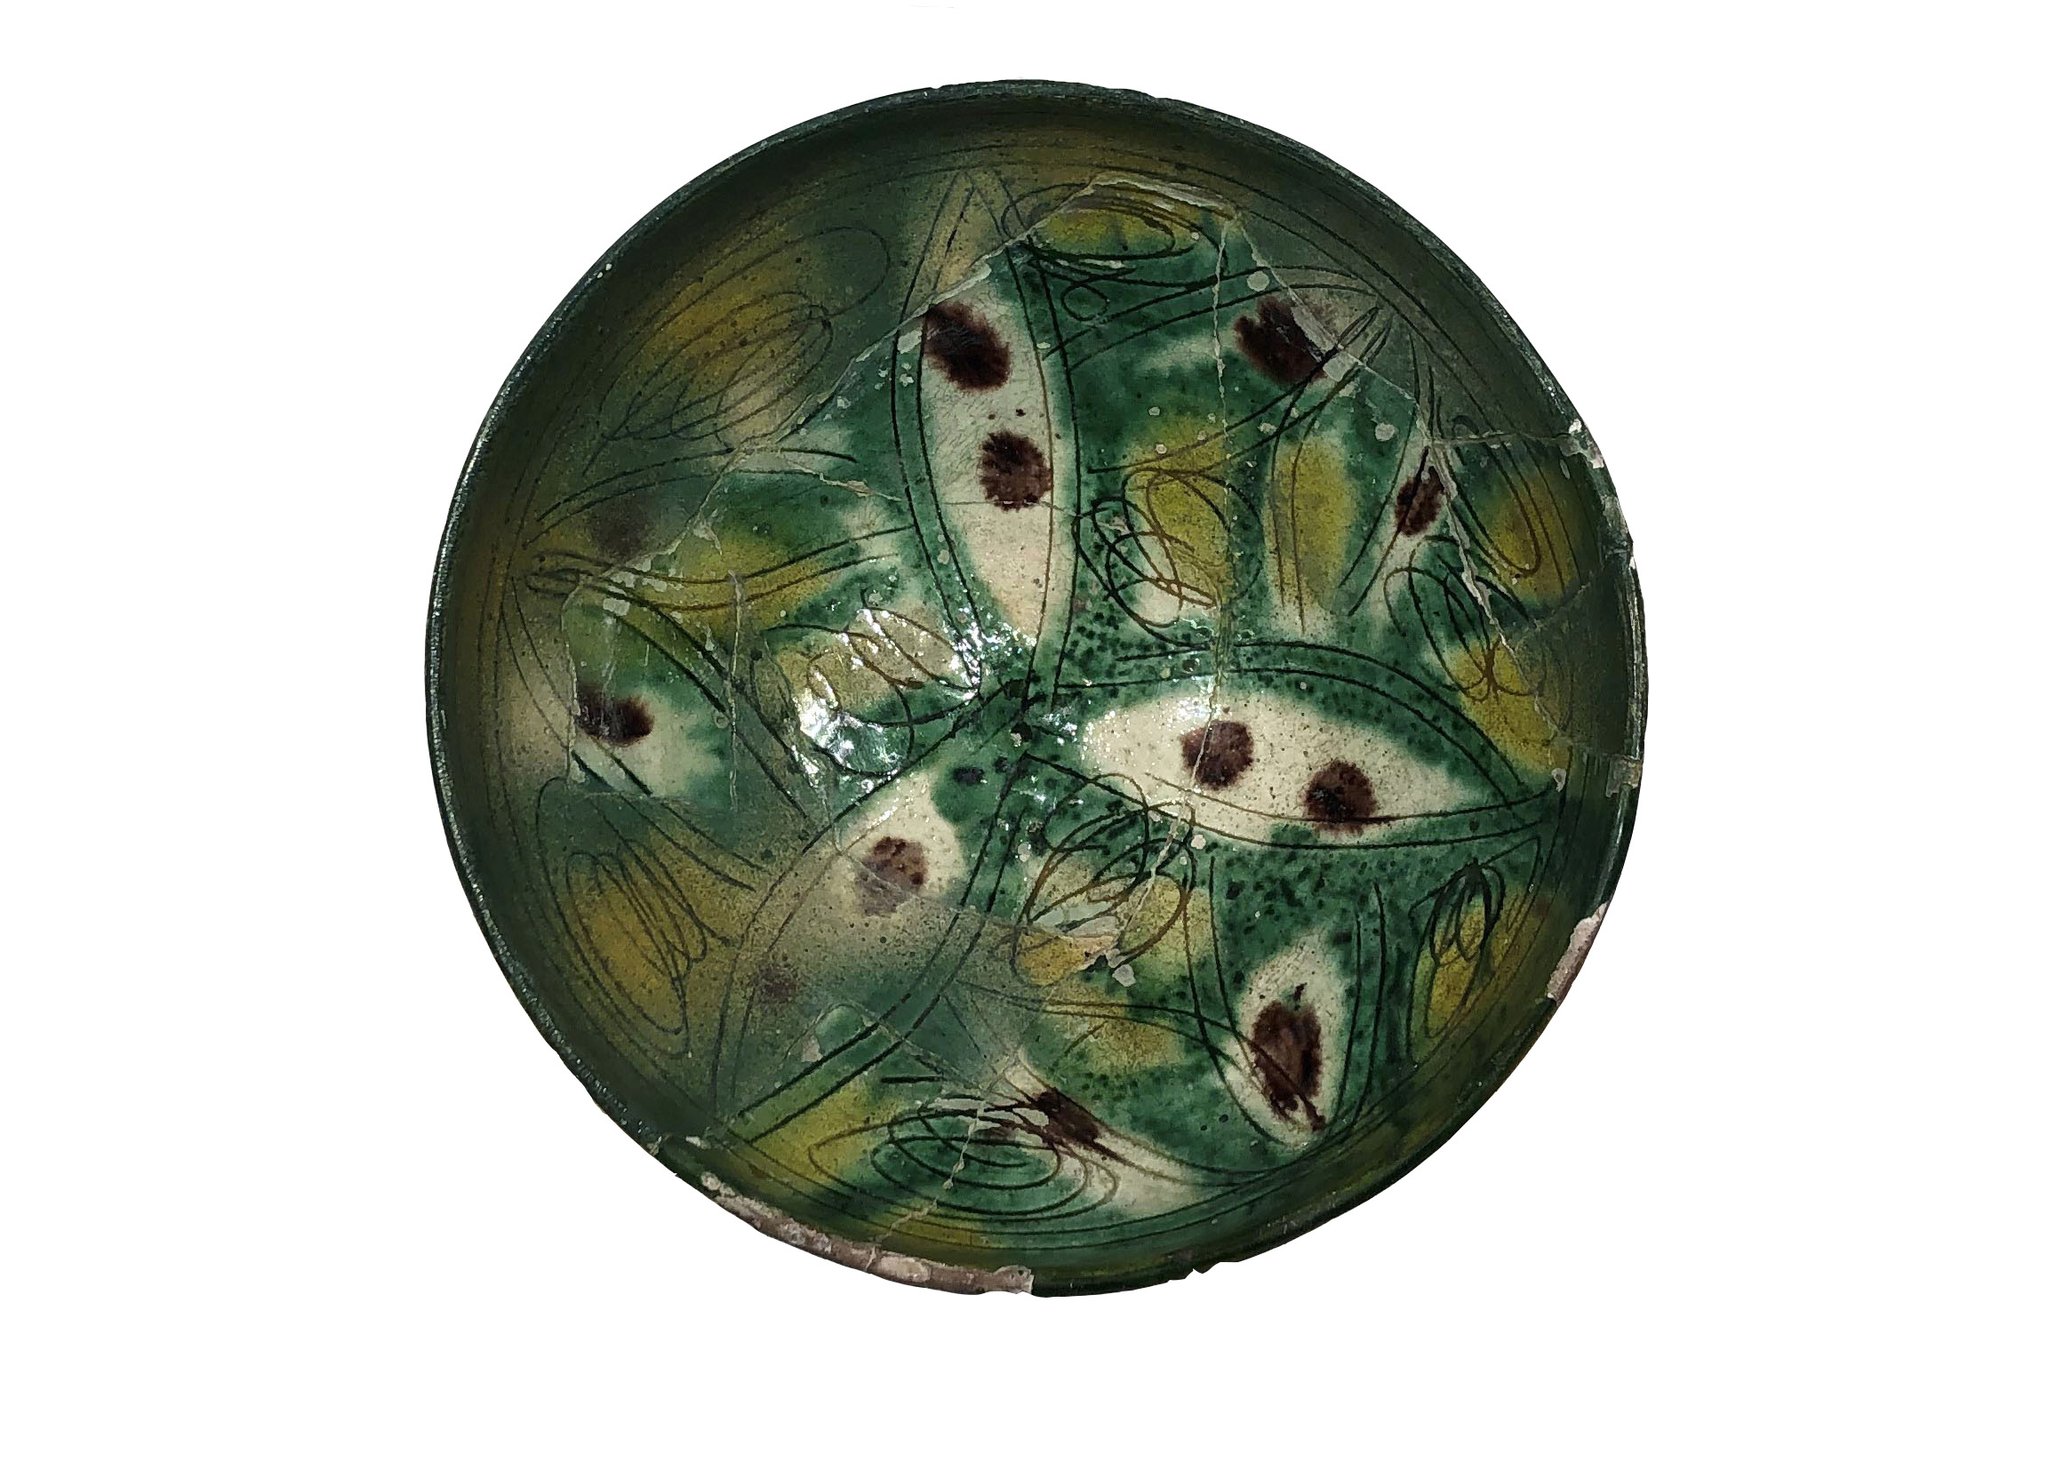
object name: bowl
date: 801-1000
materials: earthenware, glaze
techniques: incising, polychrome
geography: iran